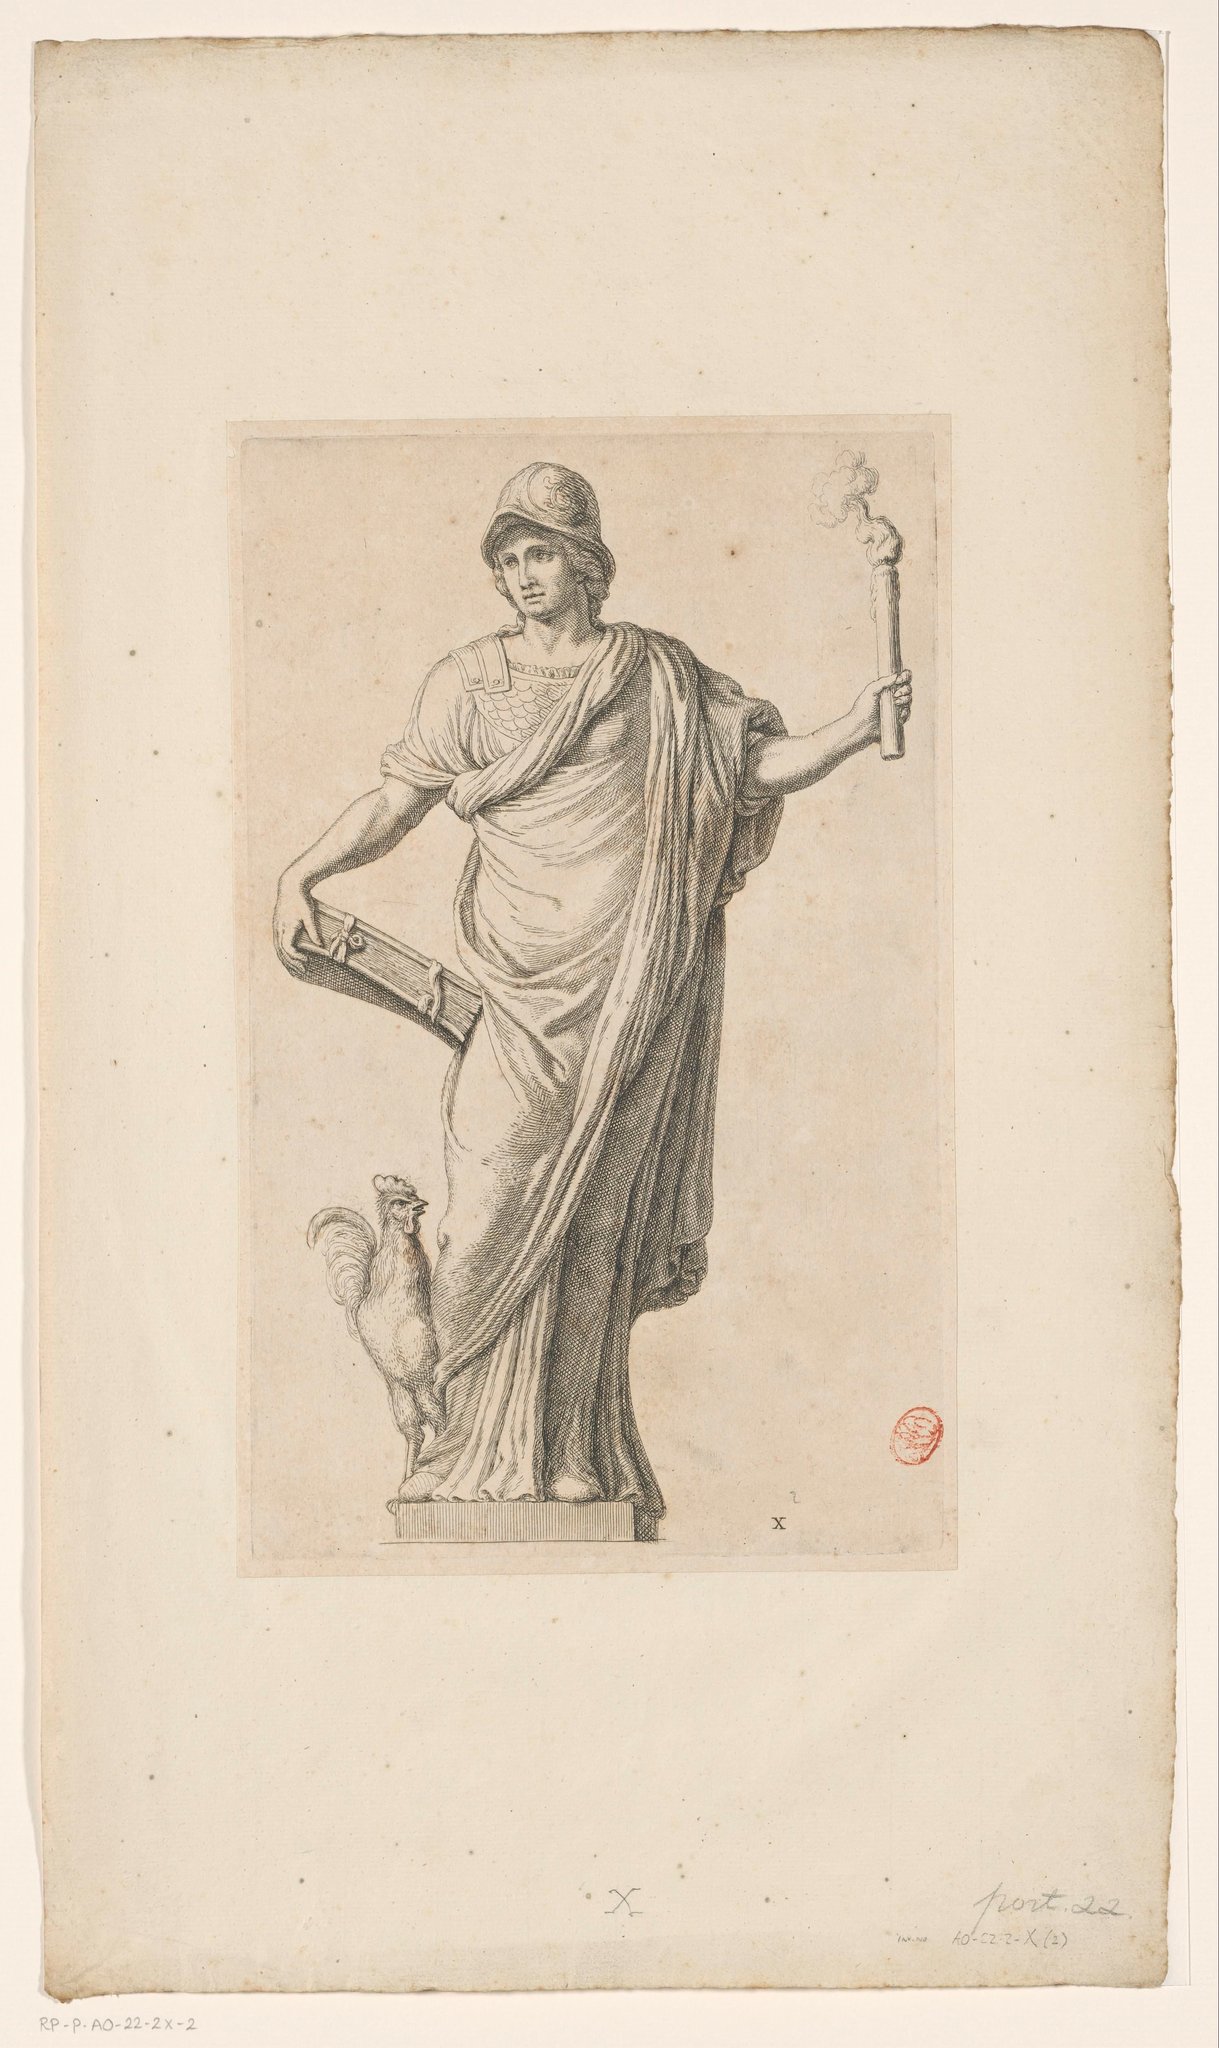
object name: book illustration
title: Beeld van Vigilantia (Waakzaamheid) op de achtergevel van het Stadhuis op de Dam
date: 1663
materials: paper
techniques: engraving, etching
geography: amsterdam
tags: attributes of aesculapius: cock, alertness, vigilance; 'guardia', 'vigilanza', 'vigilanza per difendersi & oppugnare altri' (ripa) (+ personification)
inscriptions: collector's mark: Lugt 195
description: Prent gebruikt in: Secunca pars Praecipuarum effigierum ac ornamentorum amplissime Curiae Amstelrodamensis maiori ex parte in cadido marmore effectorum per Artum Quellinium eiusdem Civitatis Statuarium / Het tweede deel Van de voornaemste Statuen ende Cieraten van 't konst-rijcke Stadt-huys van Amstelredam 'tmeeste in Marmer gemaeckt door Artus Quellinus Beelthouwer der voorseyde Stadt. Amsterdam: Artus Quellinus (I), 1663. Zie RP-P-AO-22-2-1 voor bijhorende titelpagina. Zie RP-P-AO-22-2-2 voor bijhorend register.* Zie RP-P-AO-22-2A, RP-P-AO-22-2B, RP-P-AO-22-2C-1, RP-P-AO-22-2C-2, RP-P-AO-22-2C-3, RP-P-AO-22-2C-4, RP-P-AO-22-2D-1, RP-P-AO-22-2D-2, RP-P-AO-22-2D-3, RP-P-AO-22-2E-1, RP-P-AO-22-2E-2, RP-P-AO-22-2E-3, RP-P-AO-22-2E-4, RP-P-AO-22-2F-1, RP-P-AO-22-2F-2, RP-P-AO-22-2F-3, RP-P-AO-22-2G, RP-P-AO-22-2H, RP-P-AO-22-2I, RP-P-AO-22-2K, RP-P-AO-22-2L, RP-P-AO-22-2M, RP-P-AO-22-2N, RP-P-AO-22-2O-1, RP-P-AO-22-2O-2, RP-P-AO-22-2O-3, RP-P-AO-22-2O-4, RP-P-AO-22-2O-5, RP-P-AO-22-2O-6, RP-P-AO-22-2O-7, RP-P-AO-22-2P-1, RP-P-AO-22-2P-2, RP-P-AO-22-2Q-1, RP-P-AO-22-2Q-2, RP-P-AO-22-2Q-3, RP-P-AO-22-2R-1, RP-P-AO-22-2R-2, RP-P-AO-22-2R-3, RP-P-AO-22-2S, RP-P-AO-22-2T-1, RP-P-AO-22-2T-2, RP-P-AO-22-2T-3, RP-P-AO-22-2T-4, RP-P-AO-22-2V-1, RP-P-AO-22-2V-2, RP-P-AO-22-2W-1, RP-P-AO-22-2W-2, RP-P-AO-22-2X-1 en RP-P-AO-22-2X-3 voor andere prenten uit deze publicatie. Zelfde staat van prent ook gebruikt in: Secunca pars Praecipuarum effigierum ac ornamentorum amplissime Curiae Amstelrodamensis maiori ex parte in cadido marmore effectorum per Artum Quellinium eiusdem Civitatis Statuarium / Het tweede deel Van de voornaemste Statuen ende Cieraten van 't konst-rijcke Stadt-huys van Amstelredam 'tmeeste in Marmer gemaeckt door Artus Quellinus Beelthouwer der voorseyde Stadt. Amsterdam: Frederik de Wit, 1668. Latere staat van prent ook gebruikt in: Architecture peinture et sculpture de la Maison de Ville d'Amsterdam, representee en CIX. figures en taille-douce (…). Amsterdam: David Mortier, 1719. En in: Architecture peinture et sculpture de la Maison de Ville d'Amsterdam, representee en CIX. figures en taille-douce (…). Amsterdam: Gerard Valck, 1719. En in: Bouw schilder en beeldhouwkonst, van het Stadhuis te Amsteldam, vertoont in CIX figuuren (…). Amsterdam: Covens & Mortier & Covens Jr., s.a. (1774-1783). * De prenten die in het register staan beschreven onder de letter Z zijn gemerkt met de letter X. Op de tweede staat van het register is dit aangepast.